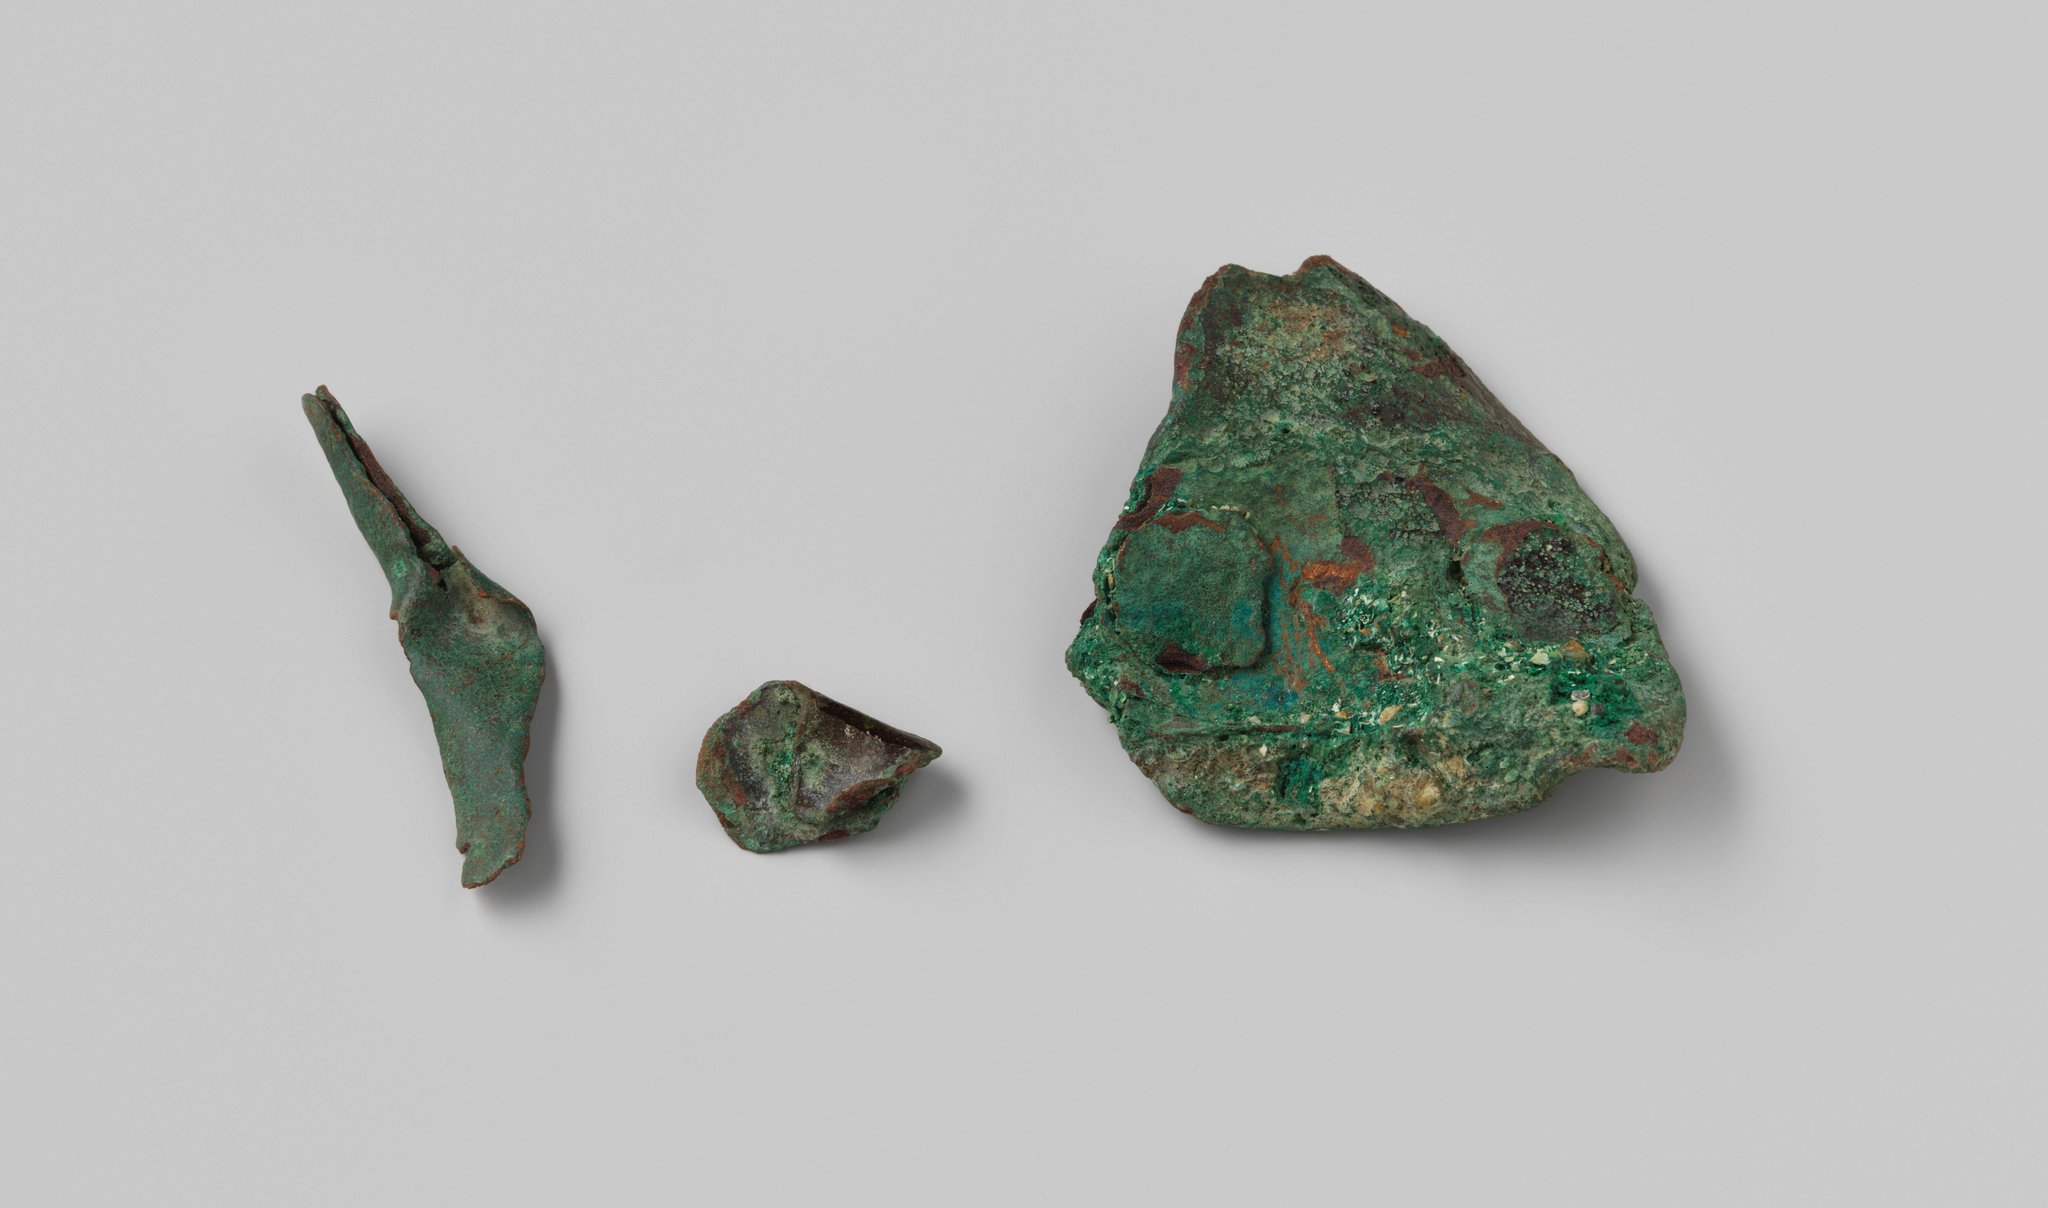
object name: fragment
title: Fragmenten koper uit het wrak van de Oost-Indiëvaarder Hollandia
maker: Anonymous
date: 1700-1743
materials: copper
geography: netherlands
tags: verenigde oostindische compagnie, hollandia (schip), annet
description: Varied parts or fragments, sheet metal fragments: worked, with rivets; fragm, sim. 80H2060, slightly curved, 2 rivets.